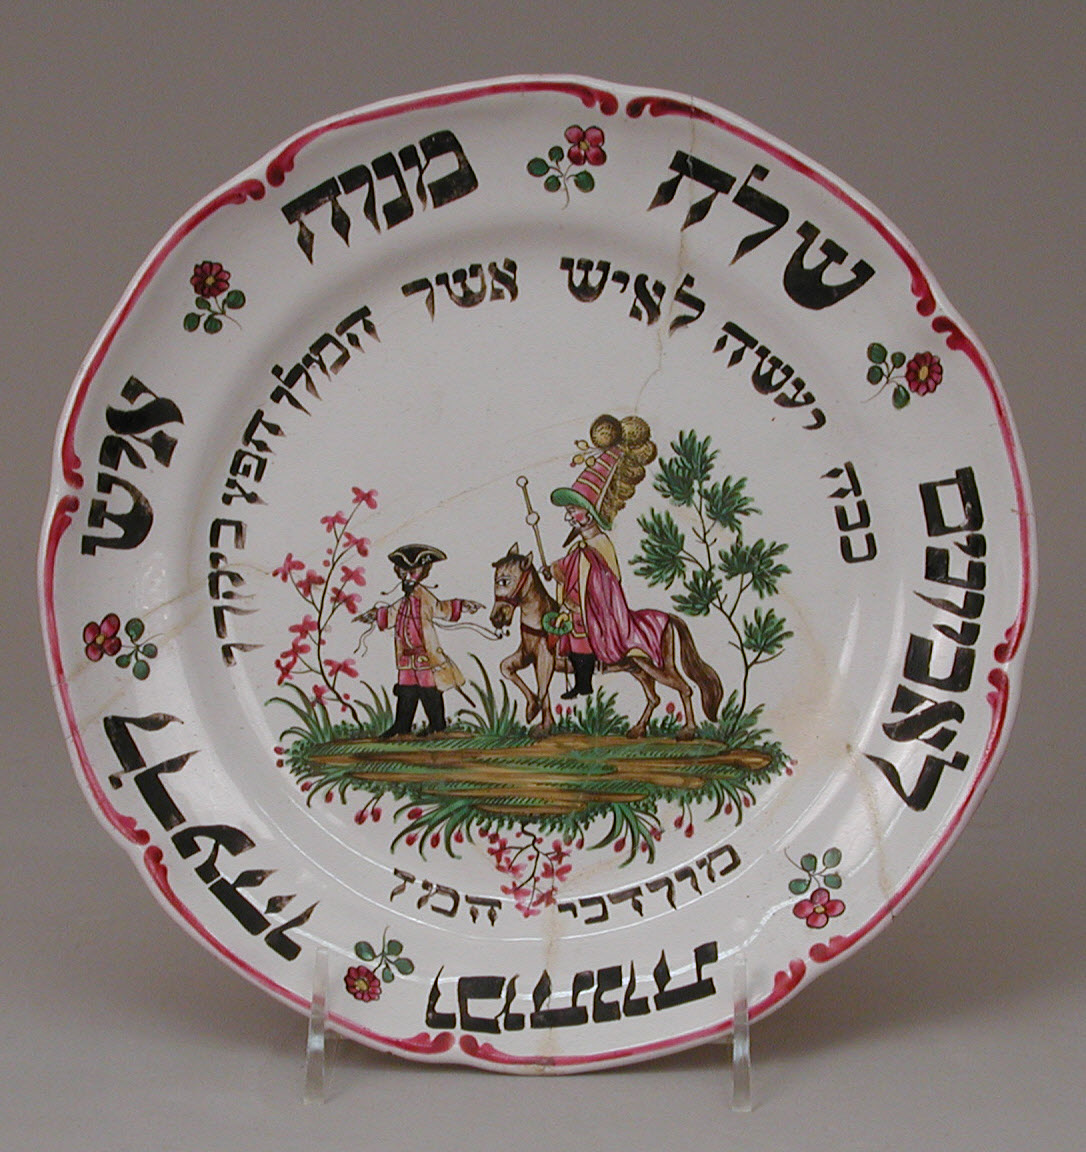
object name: plate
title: Purim plate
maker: charles loyal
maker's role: factory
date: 1760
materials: earthenware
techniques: glazing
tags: men,hebrew,horses